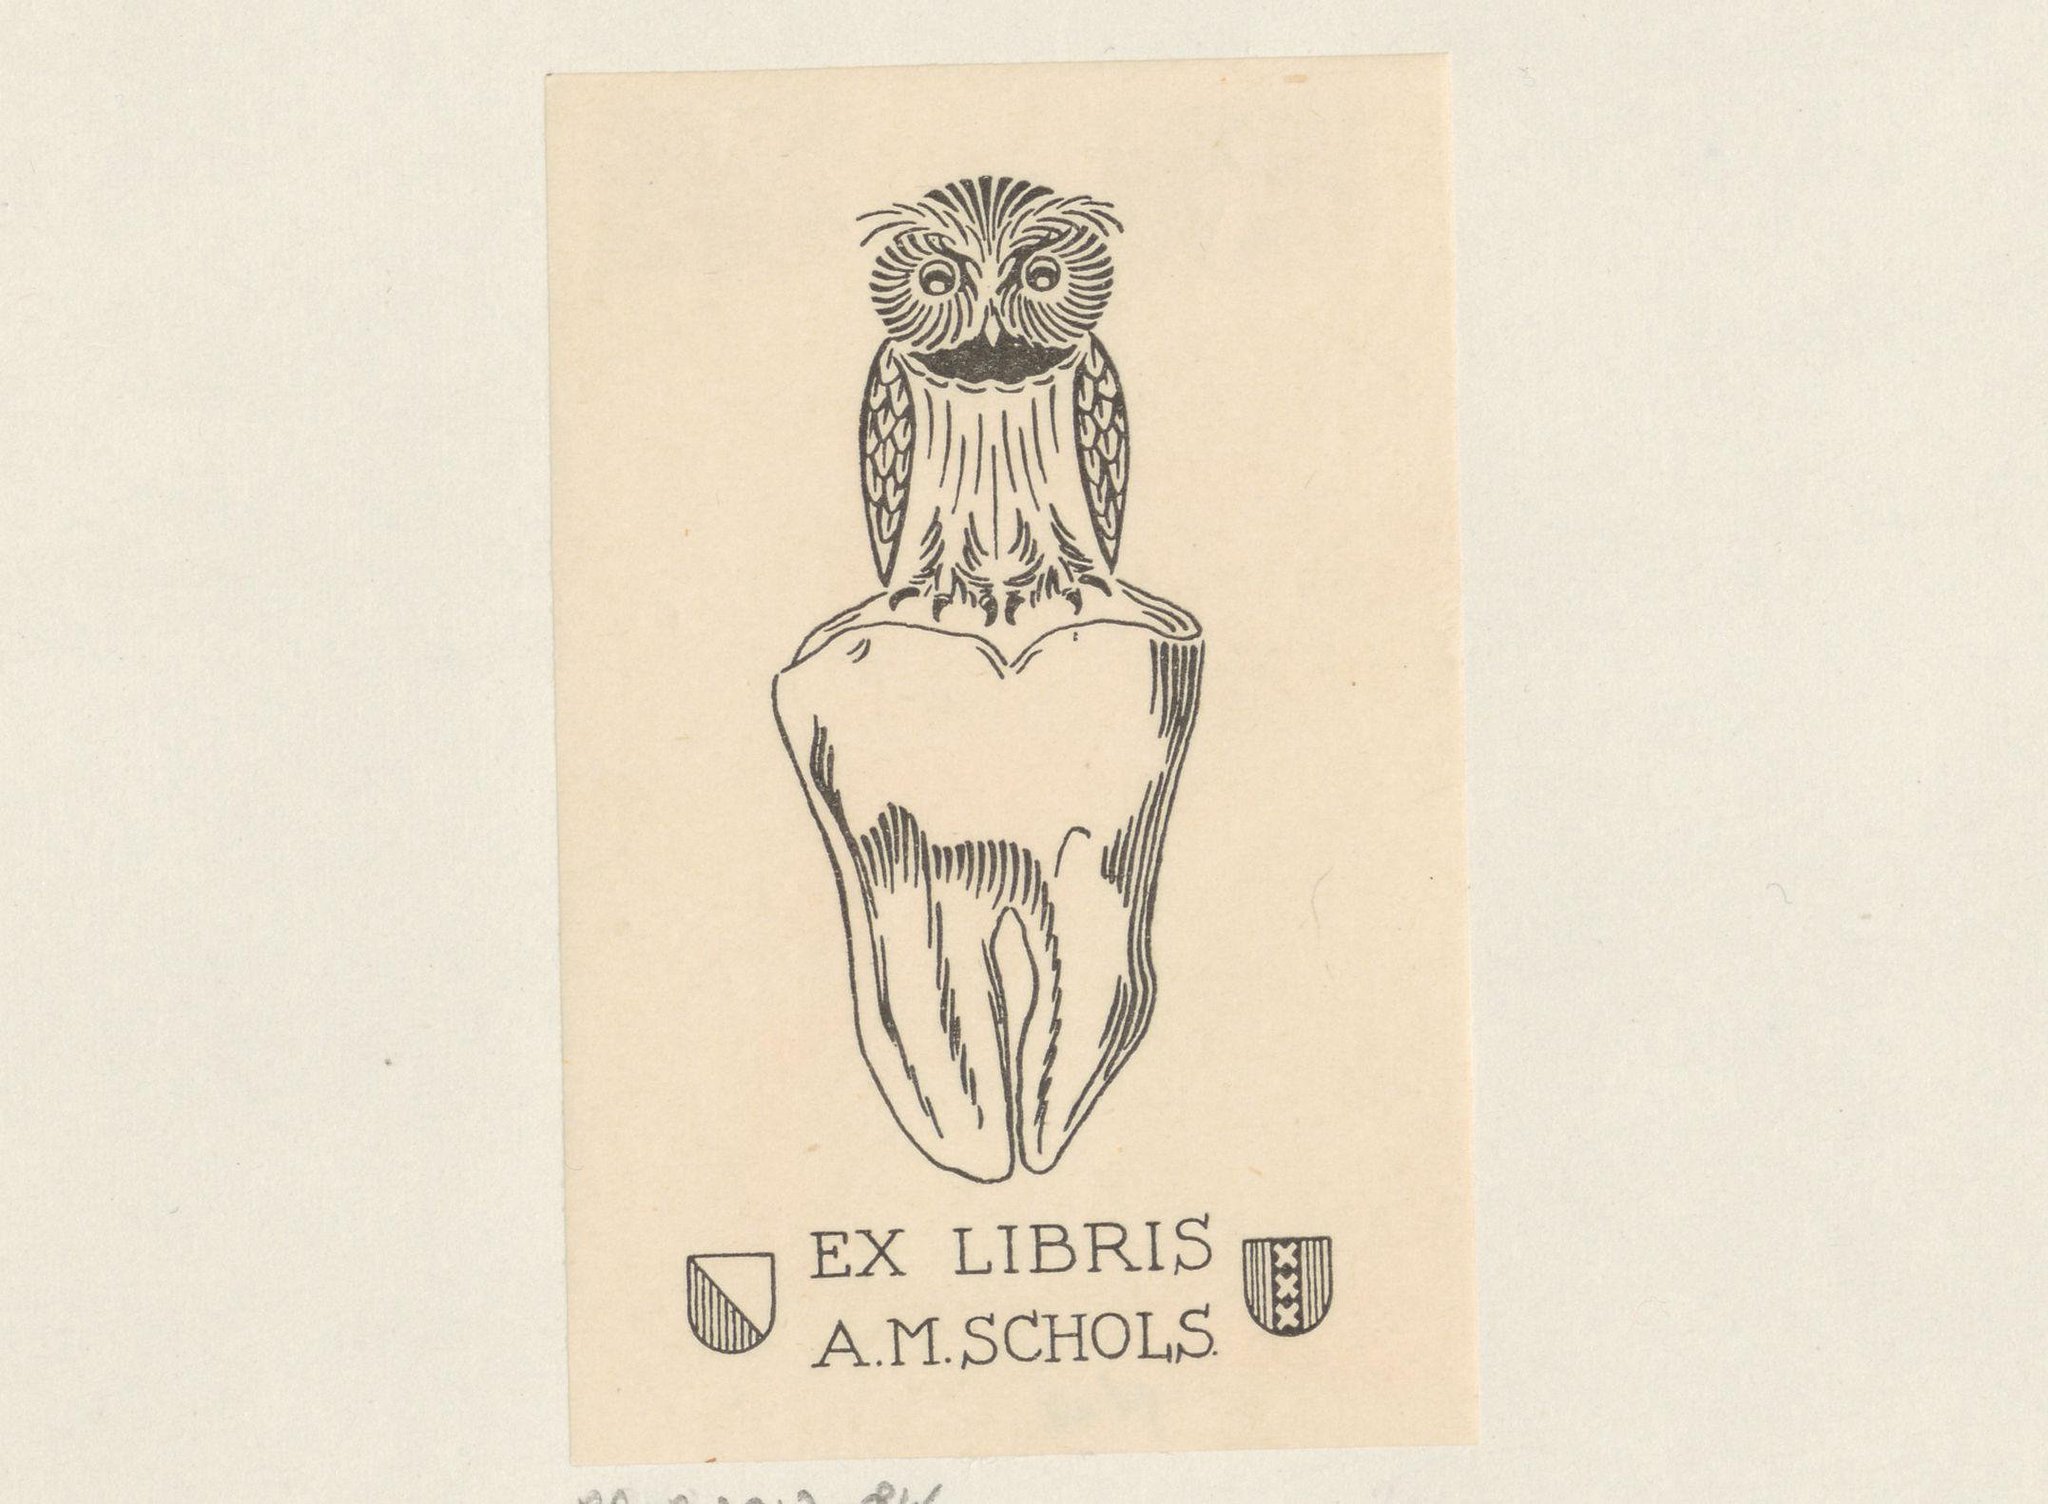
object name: bookplate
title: Ex libris van A.M. Schols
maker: Anonymous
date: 1933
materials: paper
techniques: printing block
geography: netherlands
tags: teeth, owls, amsterdam